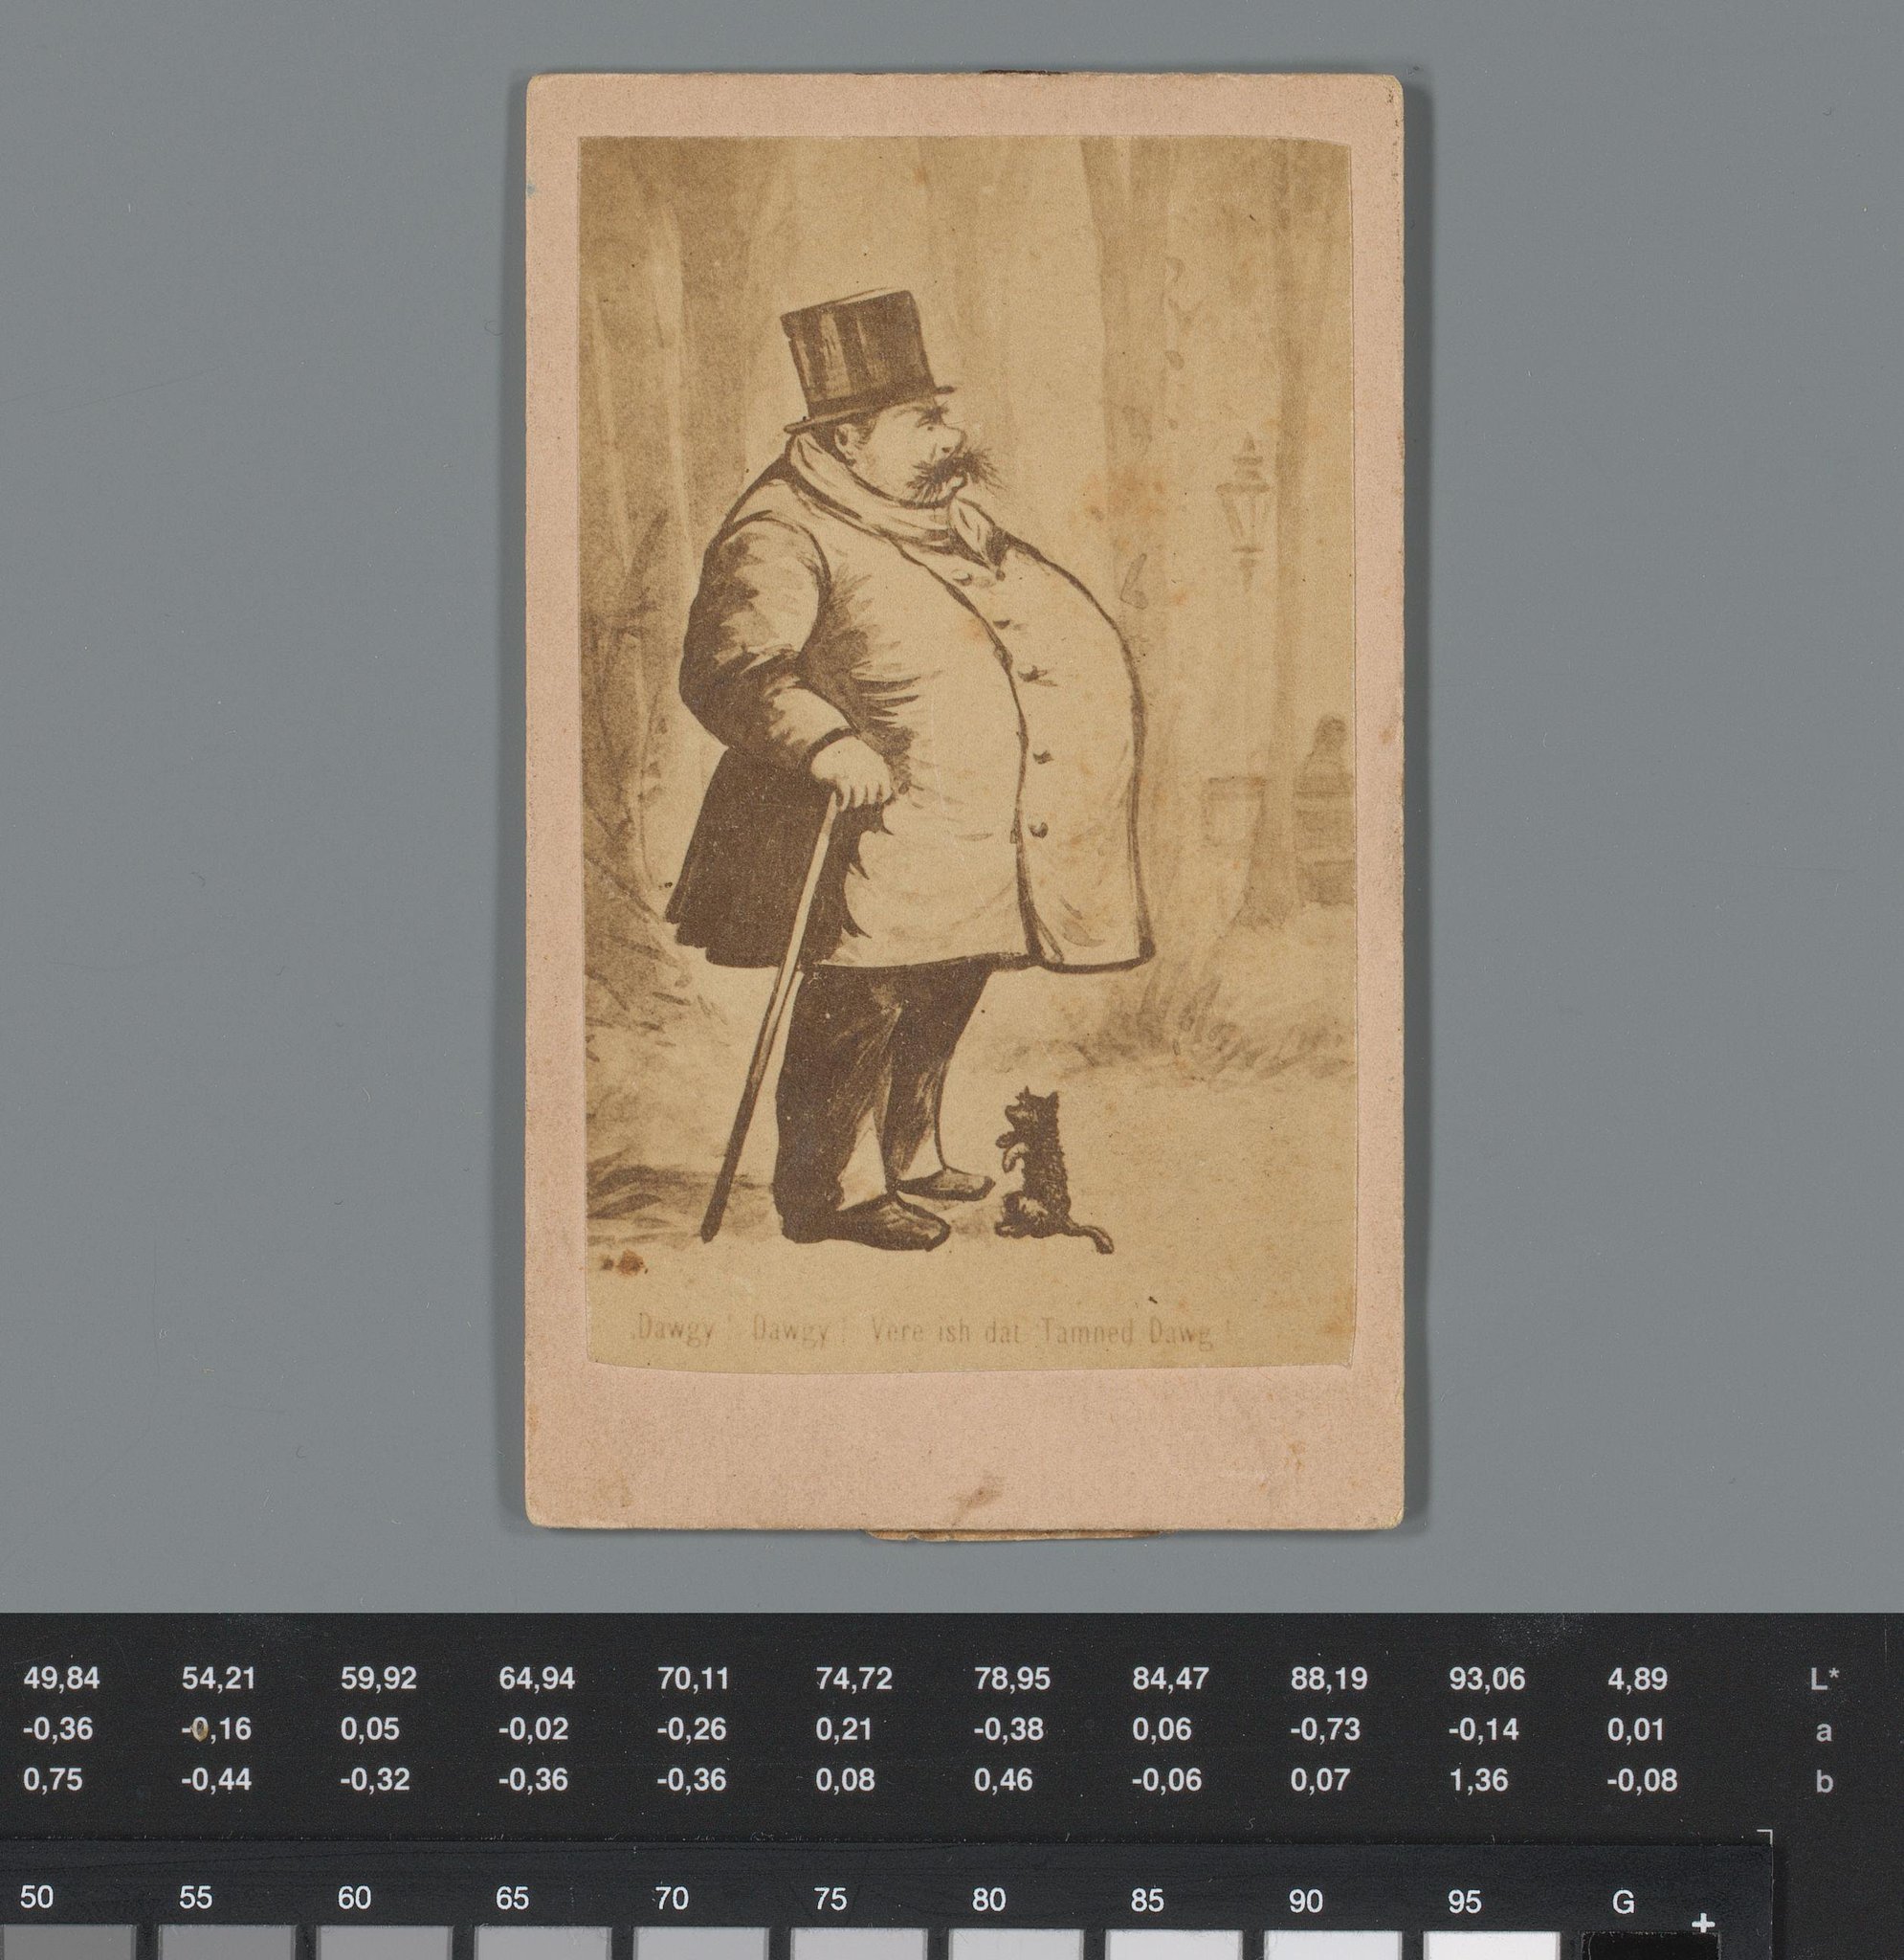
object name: photograph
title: Reclame voor boodschappen van F.H. Howe's te Boston met reproductie van een prent met karikatuur van een dikke man en kleine hond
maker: Anonymous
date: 1850-1915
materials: cardboard, photographic support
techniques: albumen print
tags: advertising, caricatures (human types), illustration ~ printed matter, book, head-gear: top hat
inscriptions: inscription: ‘GO TO / F. H. HOWE'S / FOR FINE / Groceries, Crockery, Tobacco, Cigarettes (...) Boston.’, inscription: ‘Dawgy! Dawgy! Vere ish dat Tamned Dawg!’